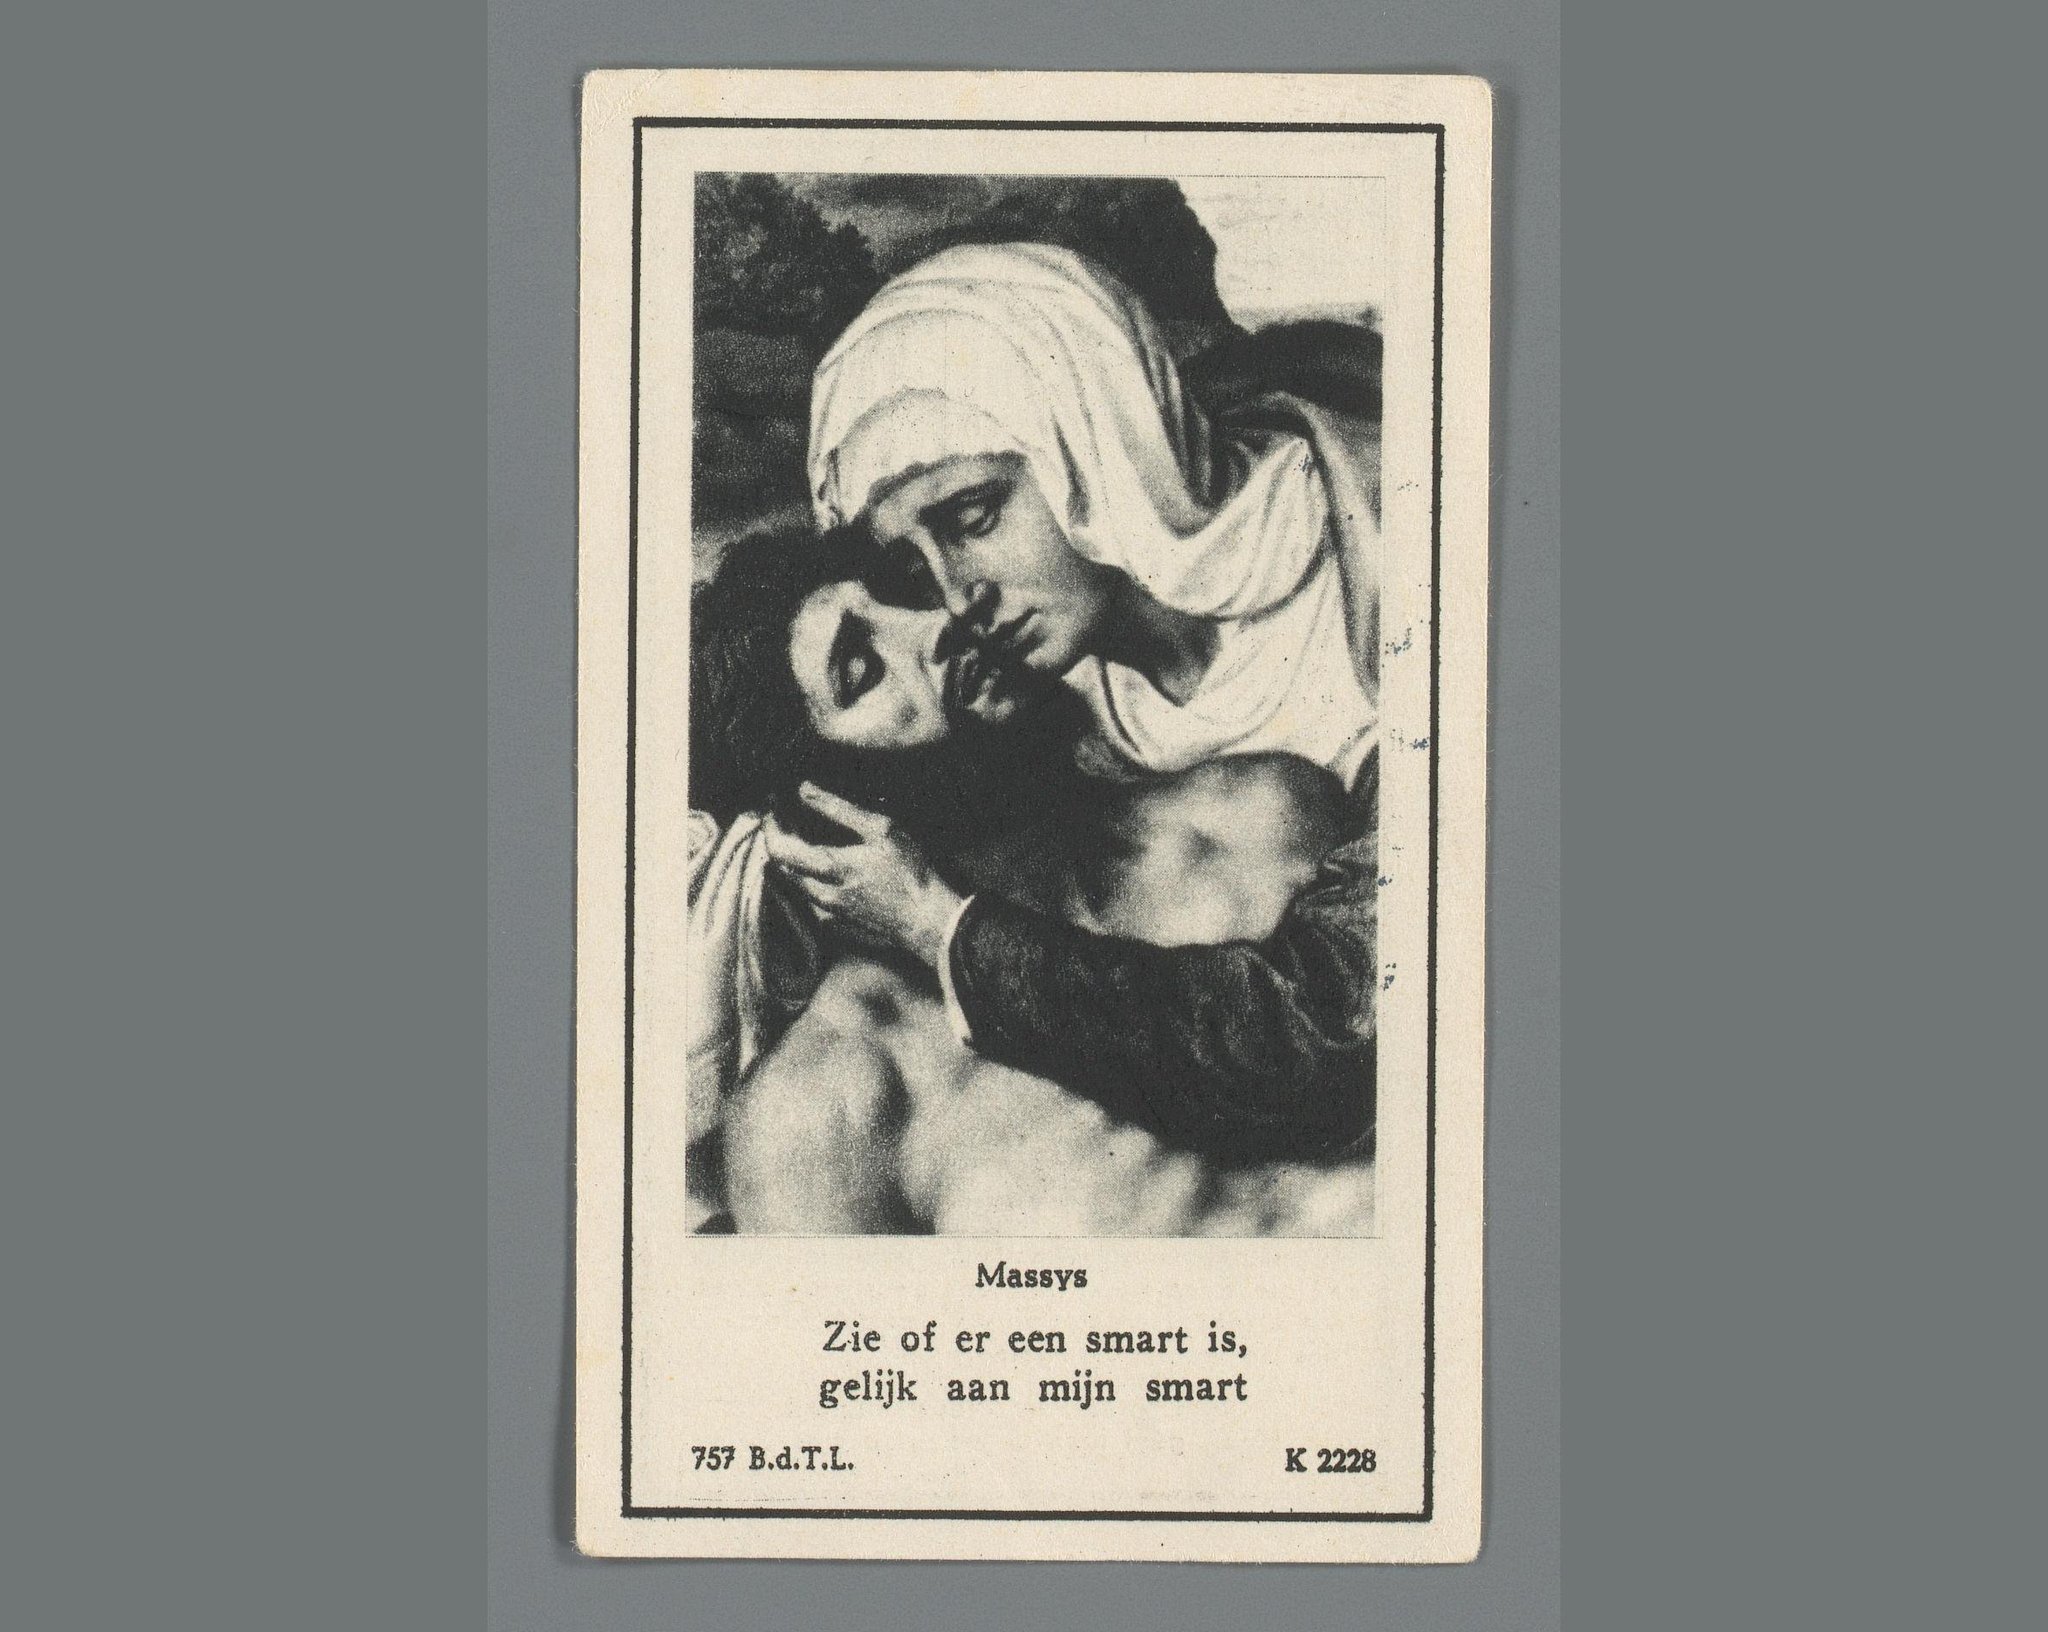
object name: prayer card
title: Fotoreproductie van een schilderij van Maria die Christus beweent, op bidprent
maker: Anonymous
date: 1942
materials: paper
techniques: letterpress printing, rotogravure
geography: netherlands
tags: 'pietà ', 'vesperbild', 'marienklage' (no others present): christ, either with or without crown of thorns, mourned by mary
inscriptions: inscription: ‘"Wie in Mij gelooft (...) Heer, geef hem de eeuwige rust...’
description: Bidprent gewijd aan Hendricus Antonius Paauwe (1892-1942).